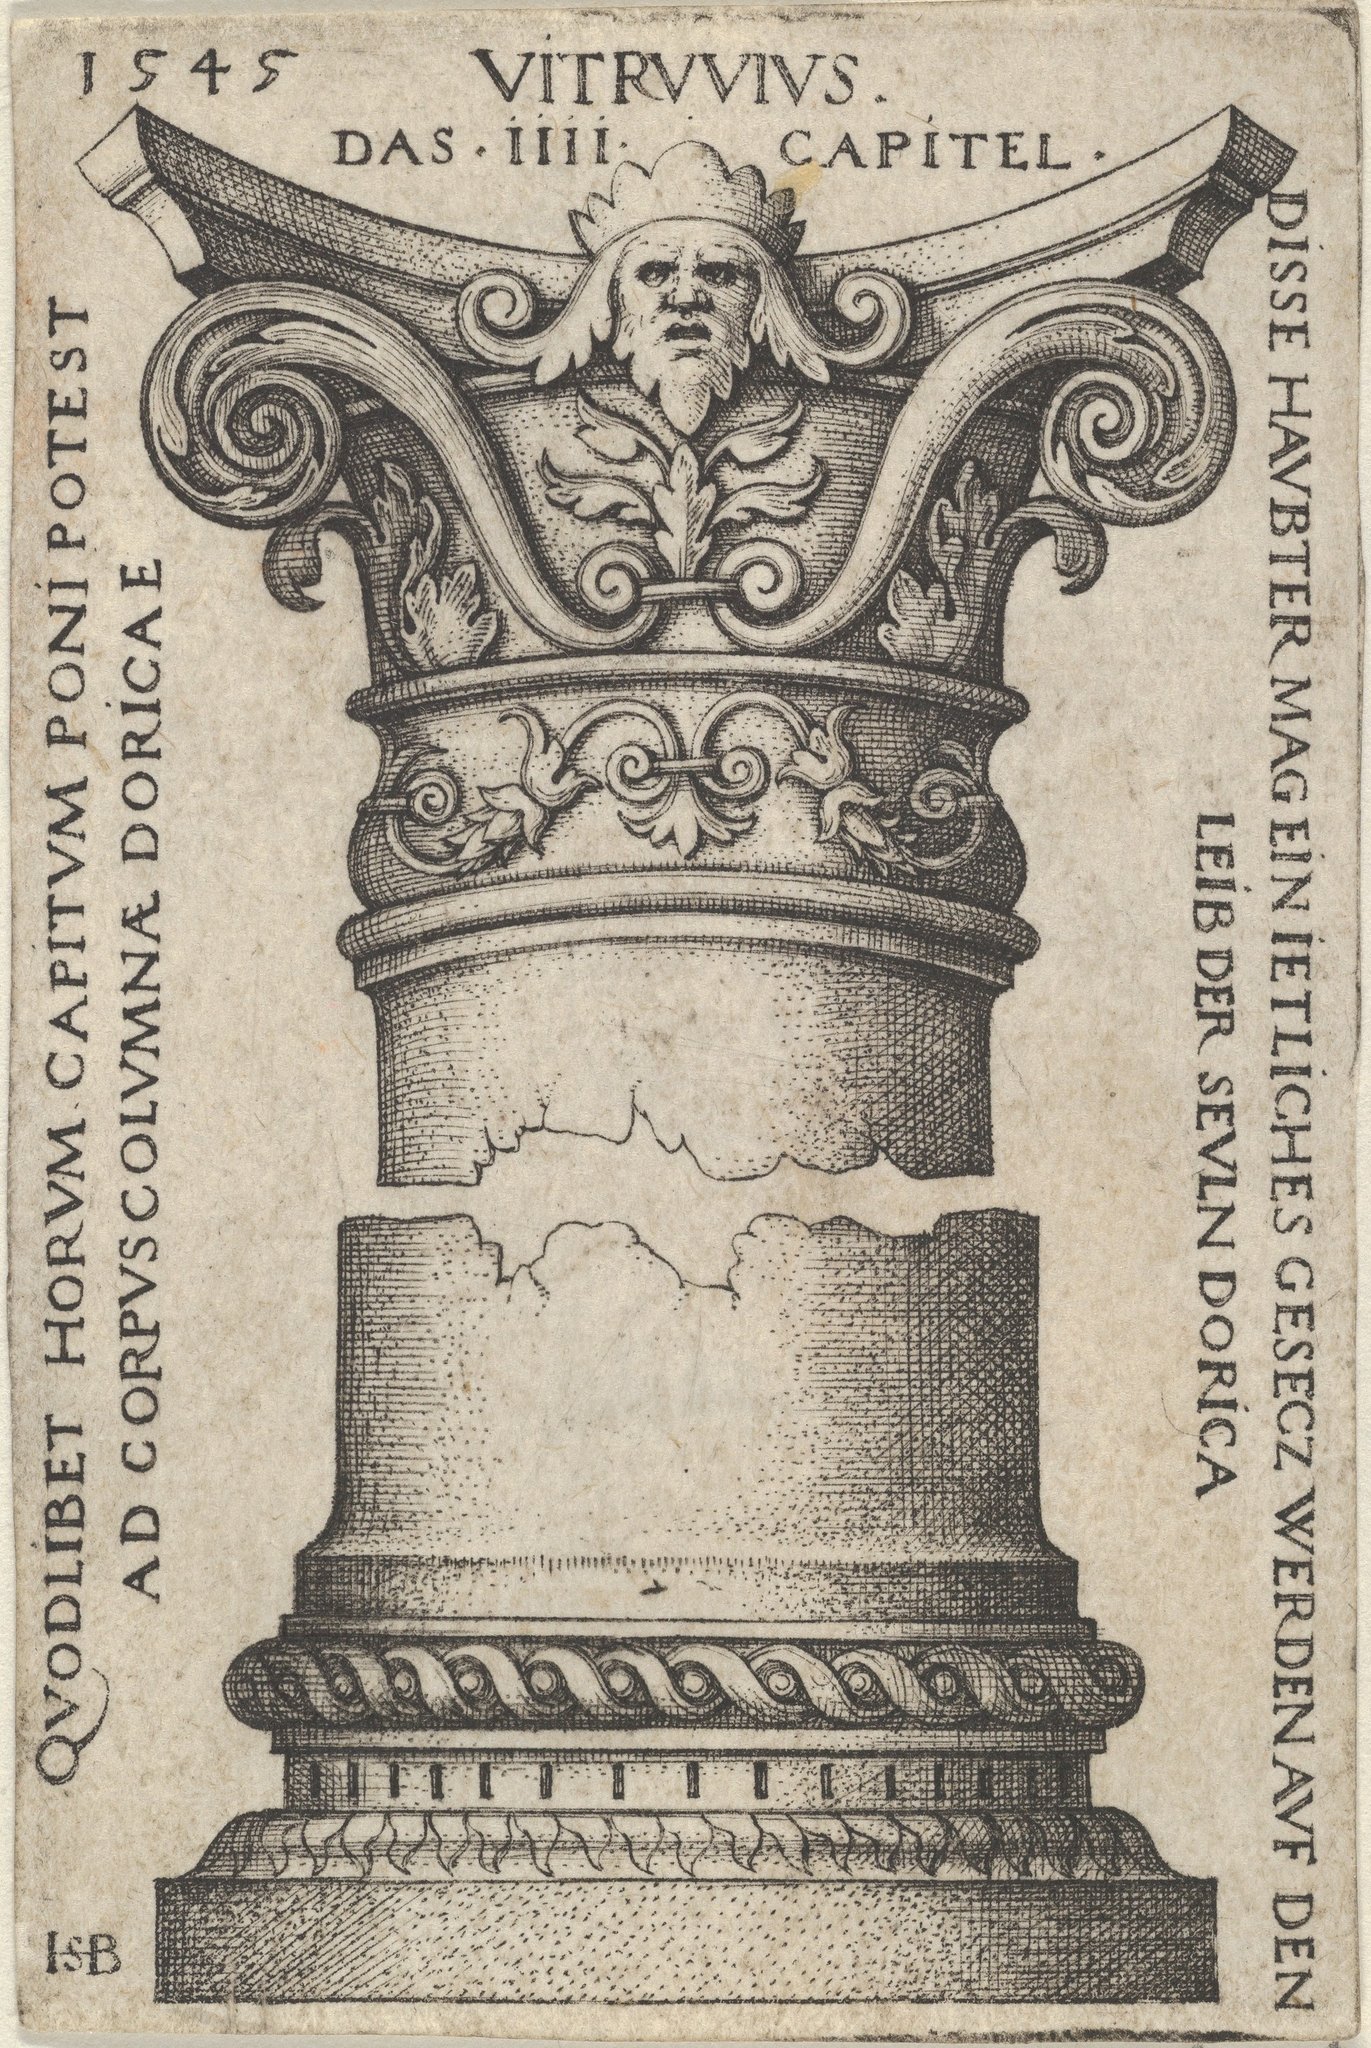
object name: print ornament architecture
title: Capital and Base of a Column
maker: sebald beham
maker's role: artist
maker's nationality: german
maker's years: 1500-1550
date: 1545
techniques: engraving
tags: capitals